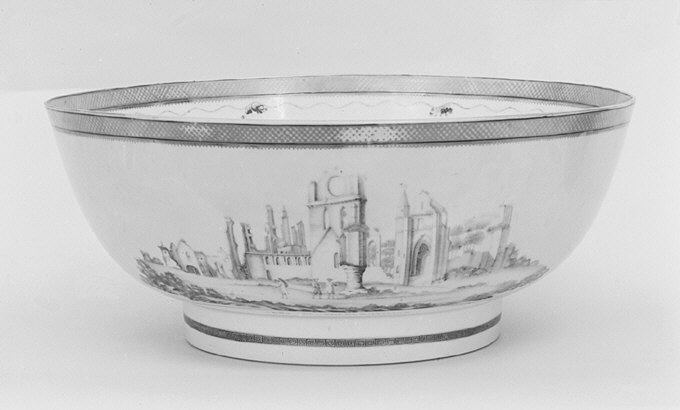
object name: punch bowl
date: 1767-1800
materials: hard paste porcelain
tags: buildings